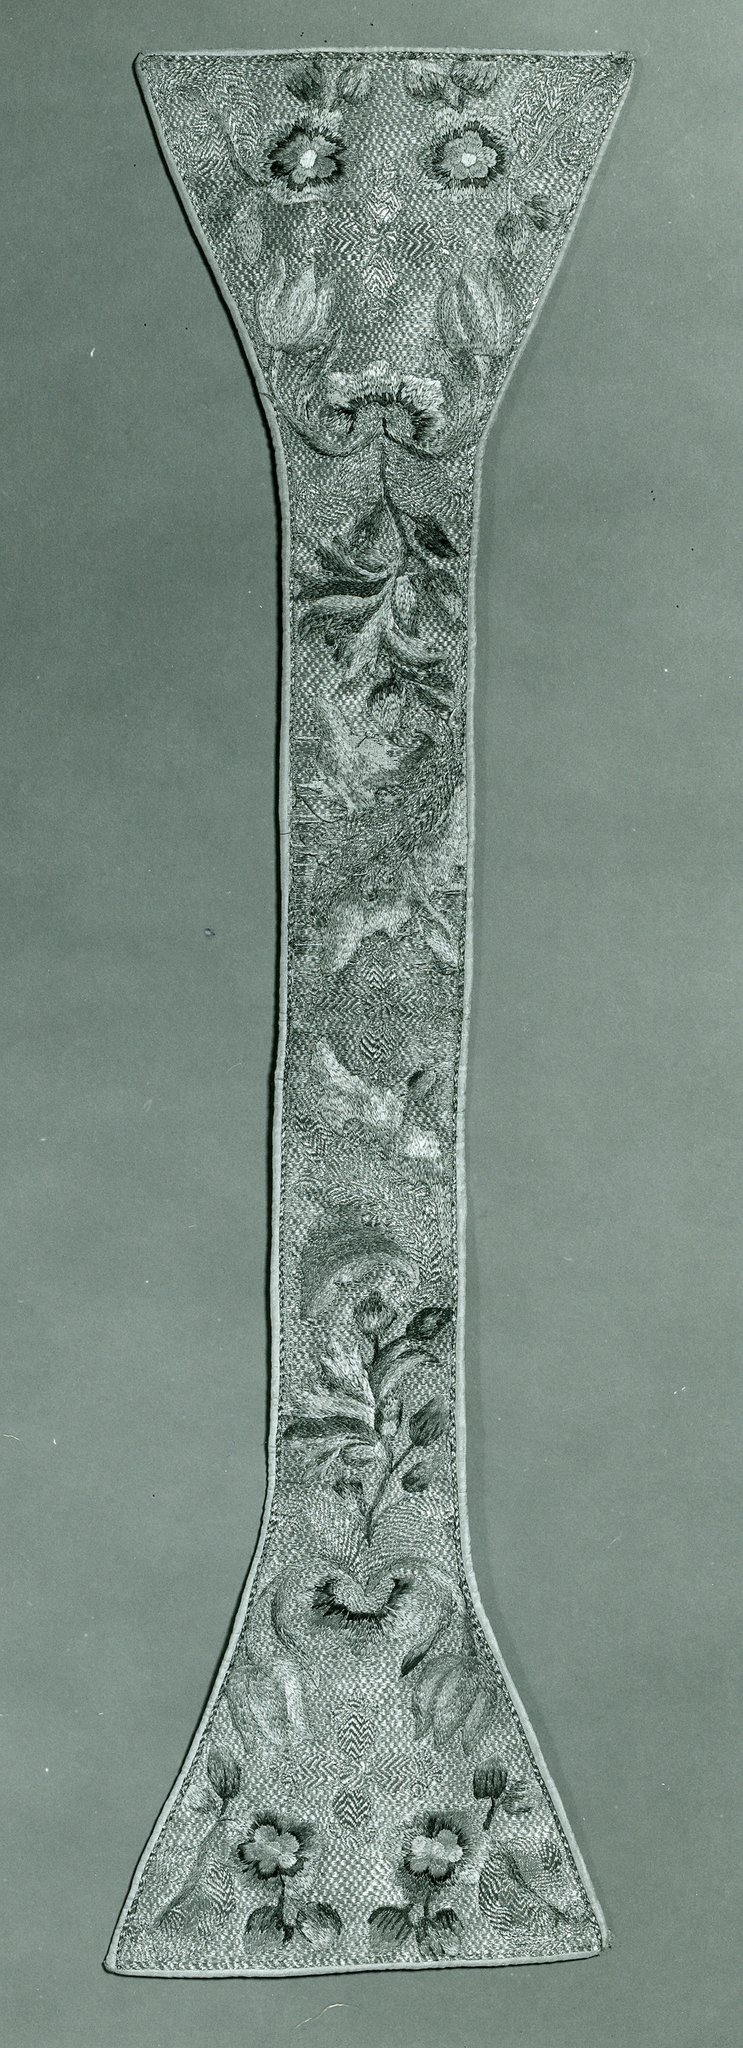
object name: maniple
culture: italian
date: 1601-1800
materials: linen, metal, silk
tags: flowers